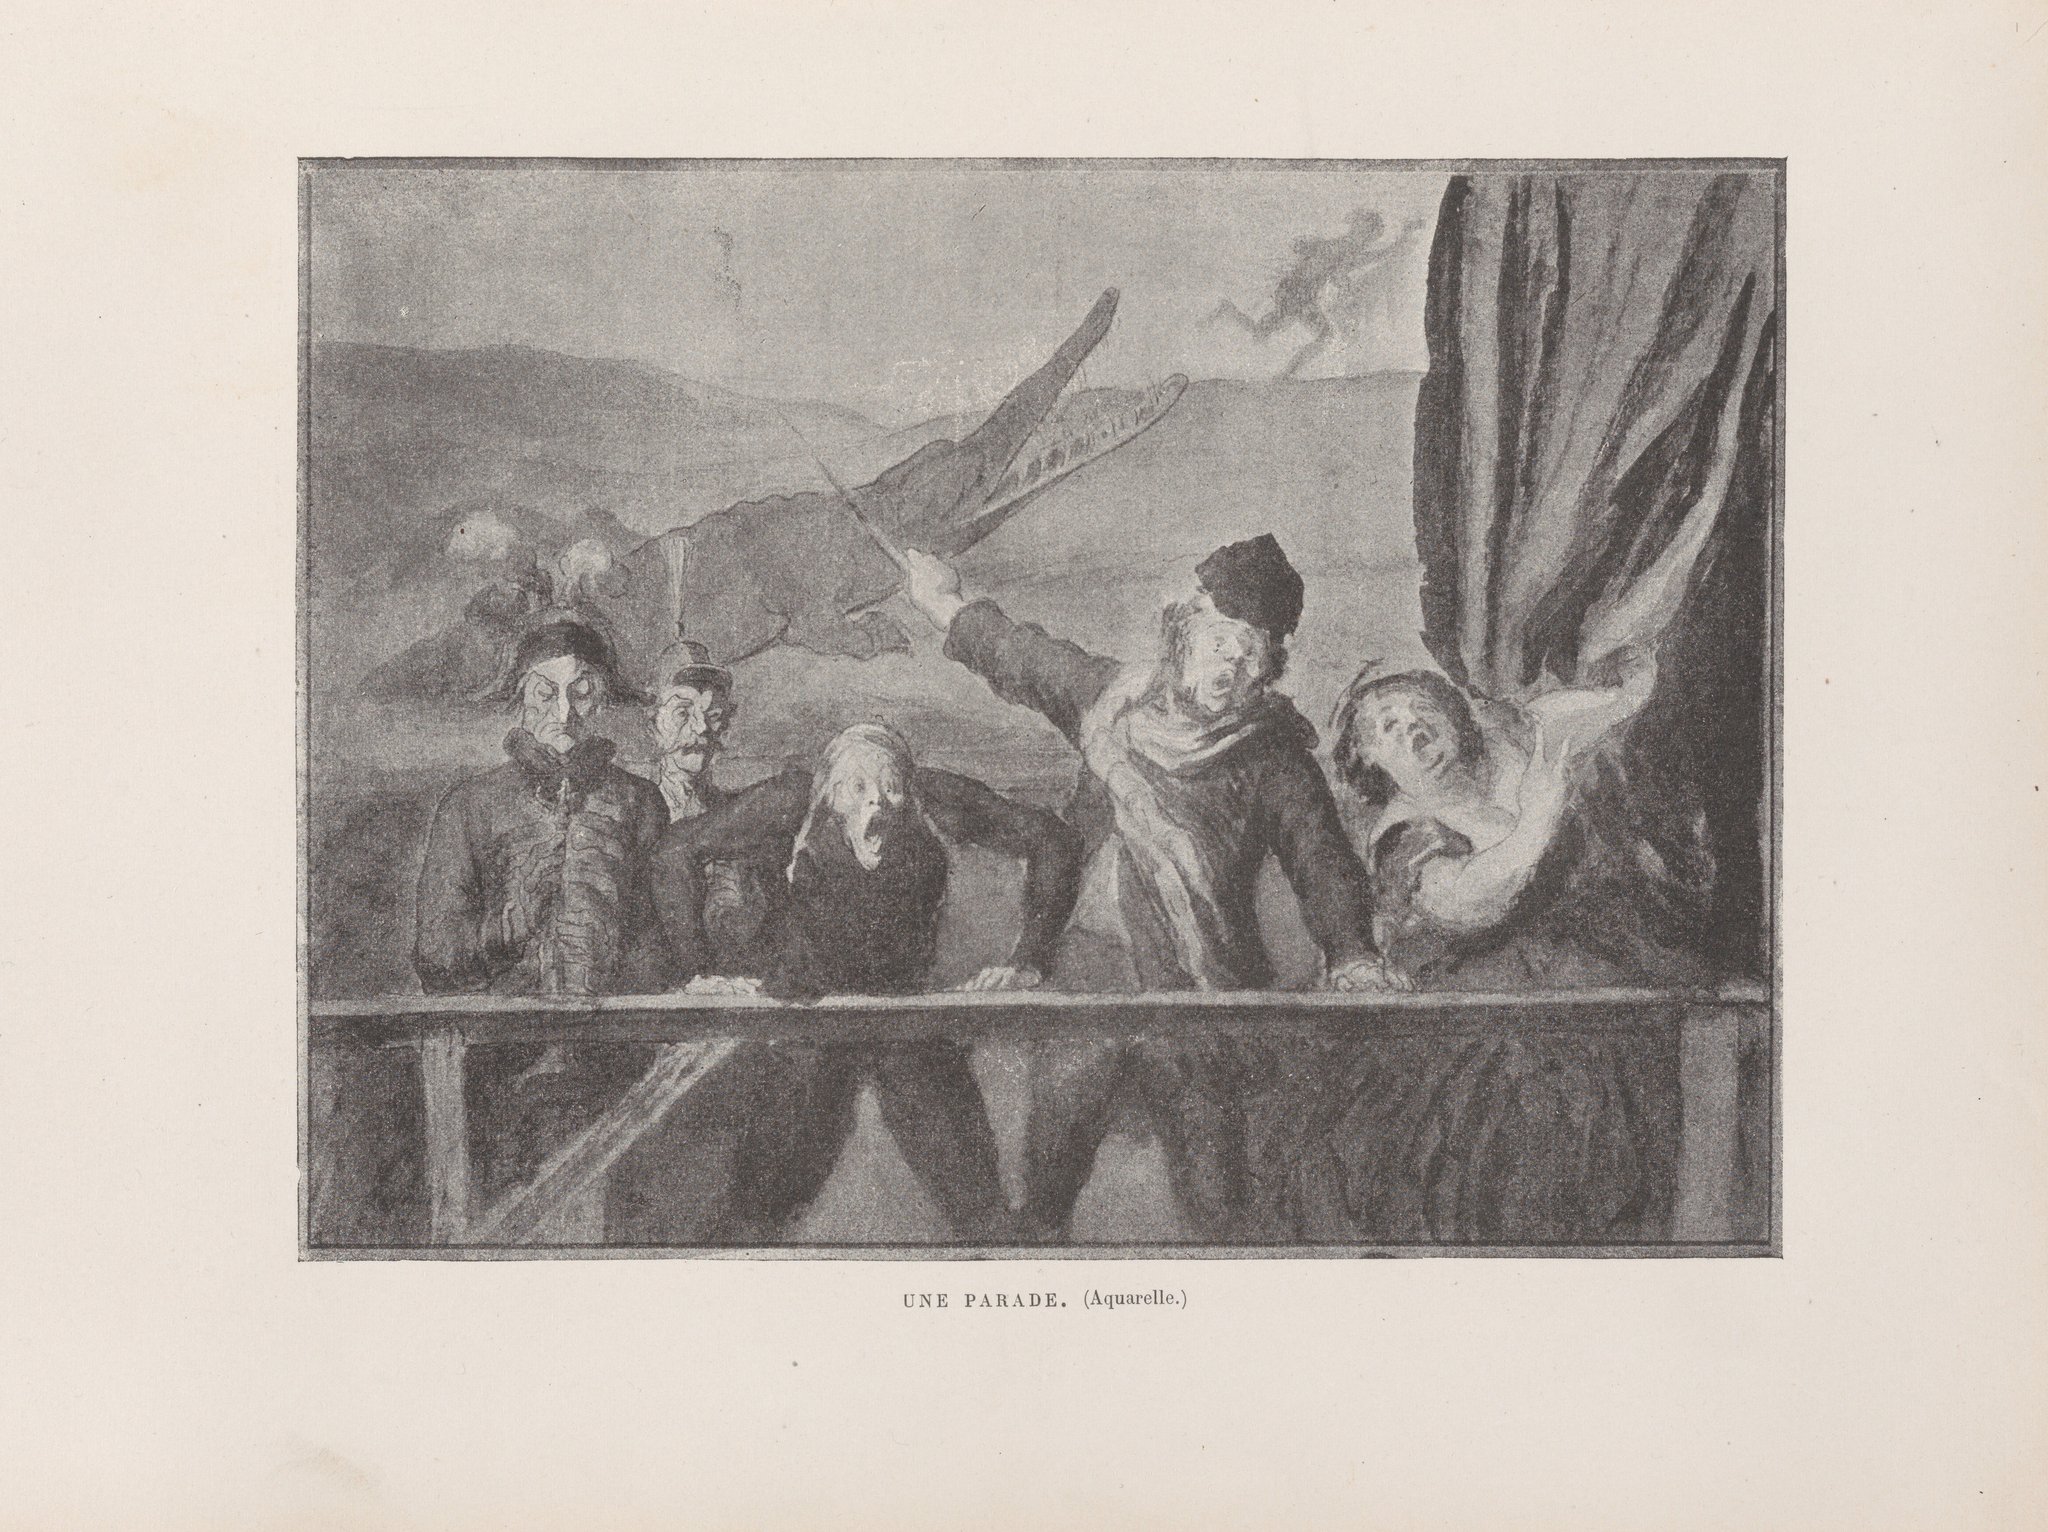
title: Honoré Daumier, l'homme et l'œuvre : ouvrage orné d'un portrait à l'ea-forte, de deux héliogravures et de 47 illustrations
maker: arsène alexandre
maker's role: author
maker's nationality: french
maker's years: 1859-1937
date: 1888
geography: france